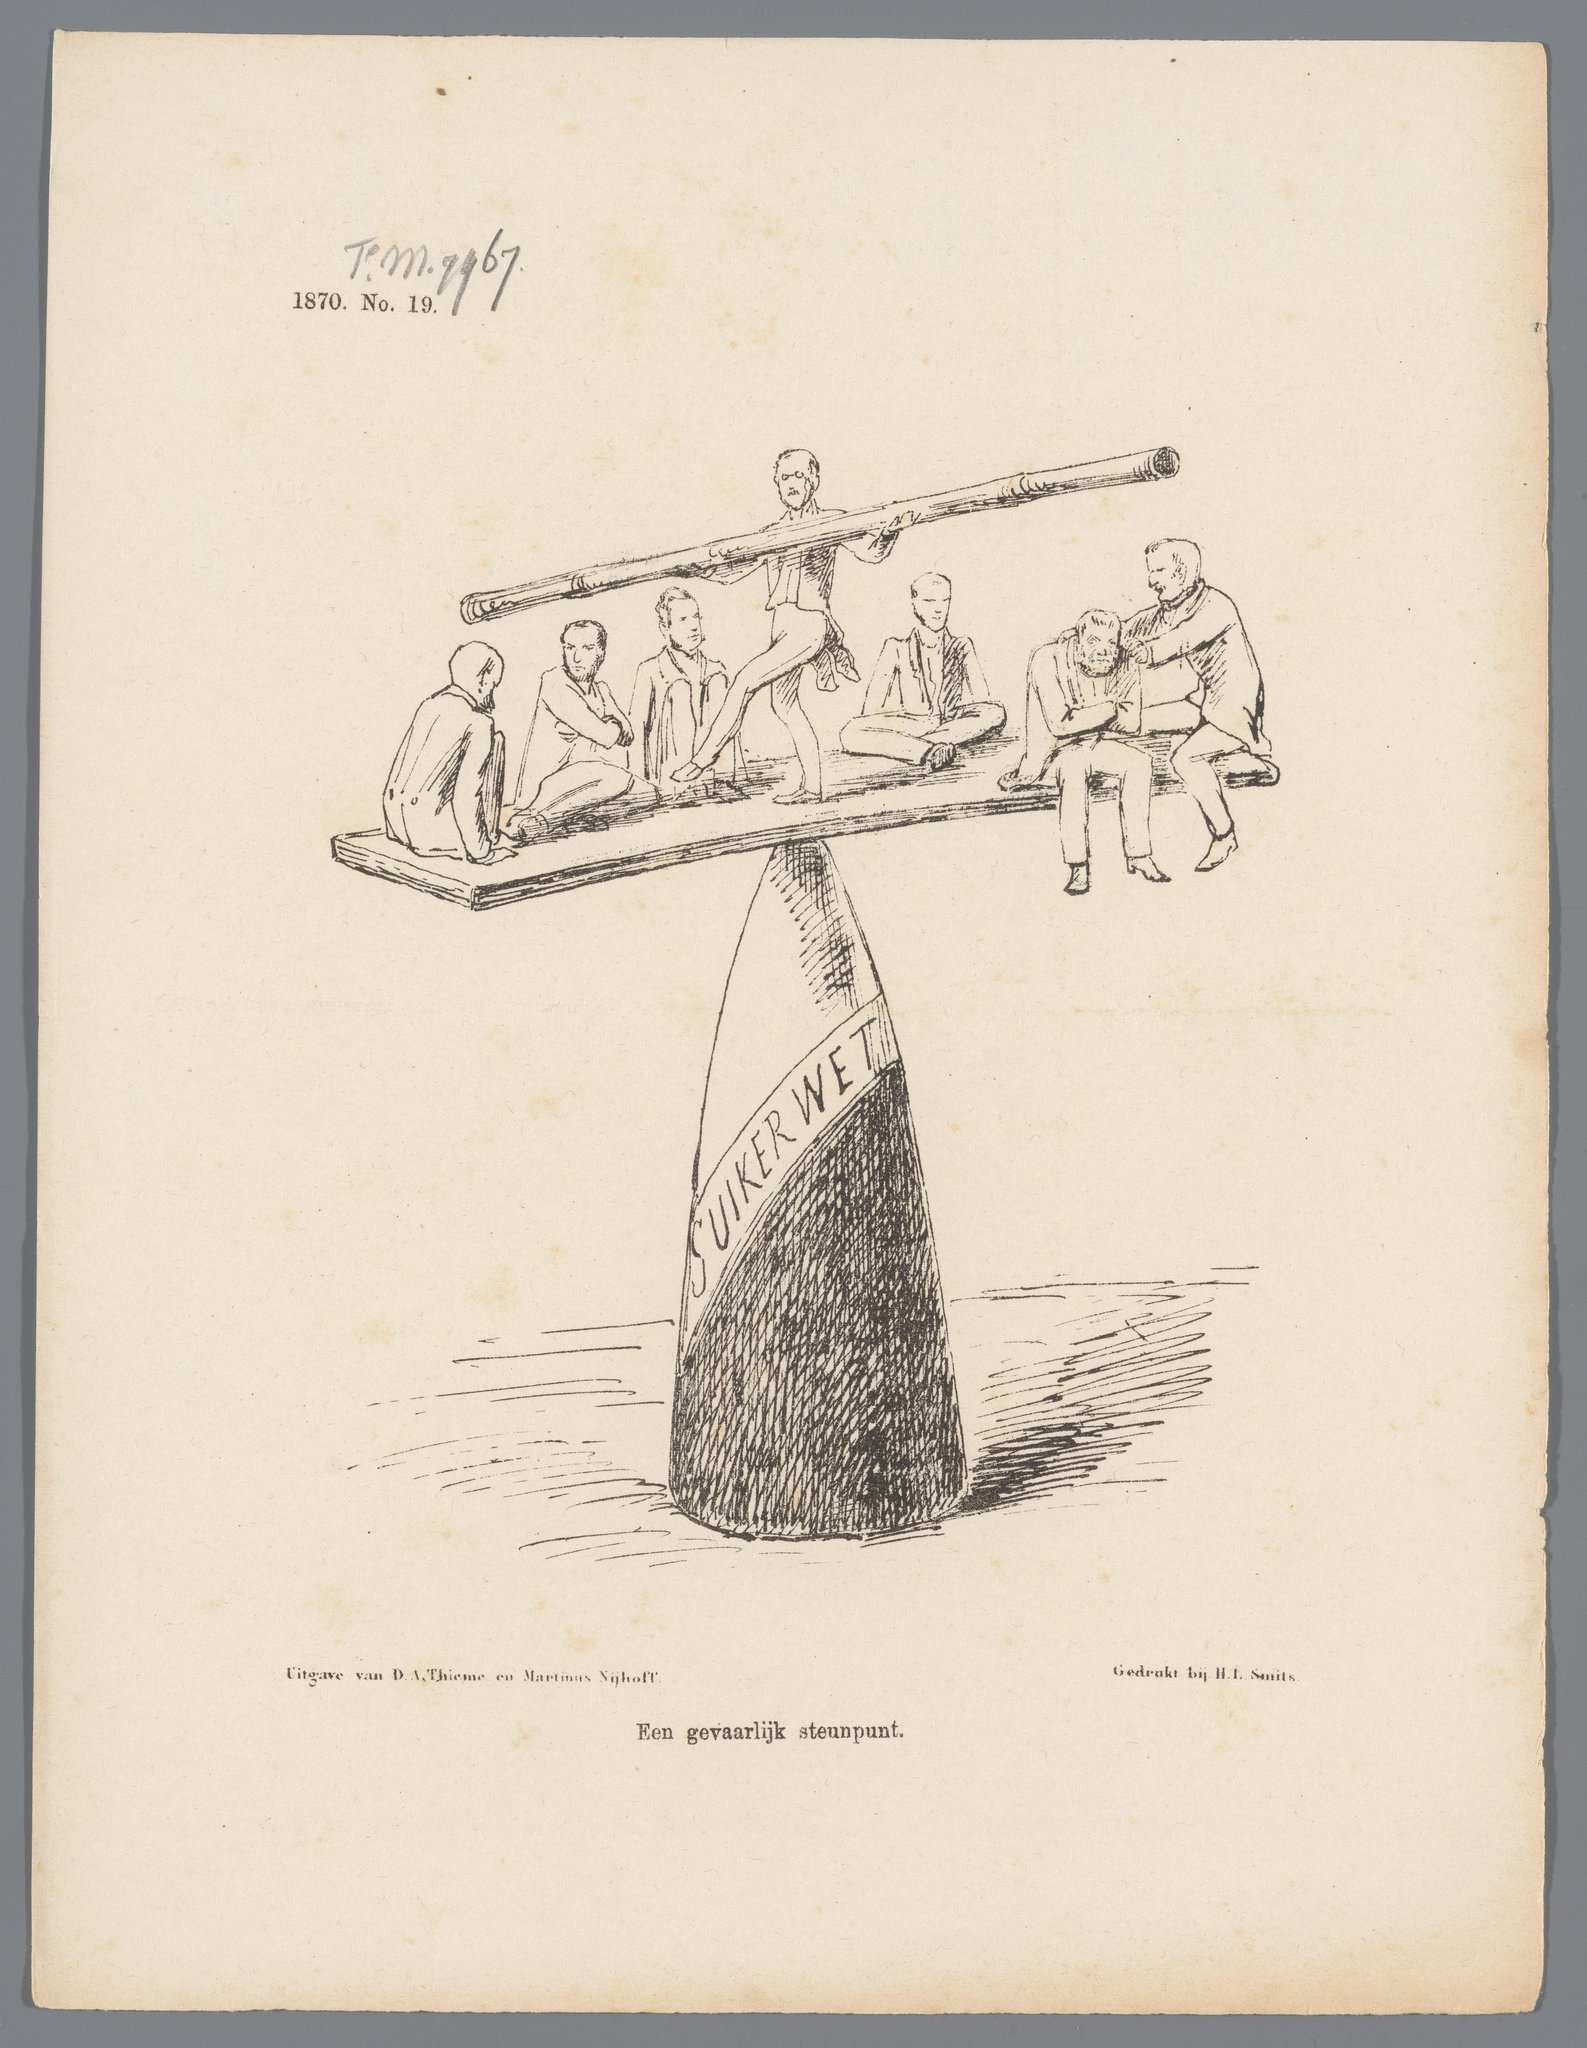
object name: cartoon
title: Een gevaarlijk steunpunt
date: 1870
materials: paper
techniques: lithograph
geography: netherlands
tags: loaf-sugar, tight-ropewalker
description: Spotprent op precaire situatie waarin het kabinet Fock-De Waal zich bevindt. Het kabinet balancerend op het puntje van een suikerbrood, nav van het aannemen of verwerpen van de suikerwet. Plaat verschenen bij het weekblad De Nederlandsche Spectator, nr. 19, 1870.